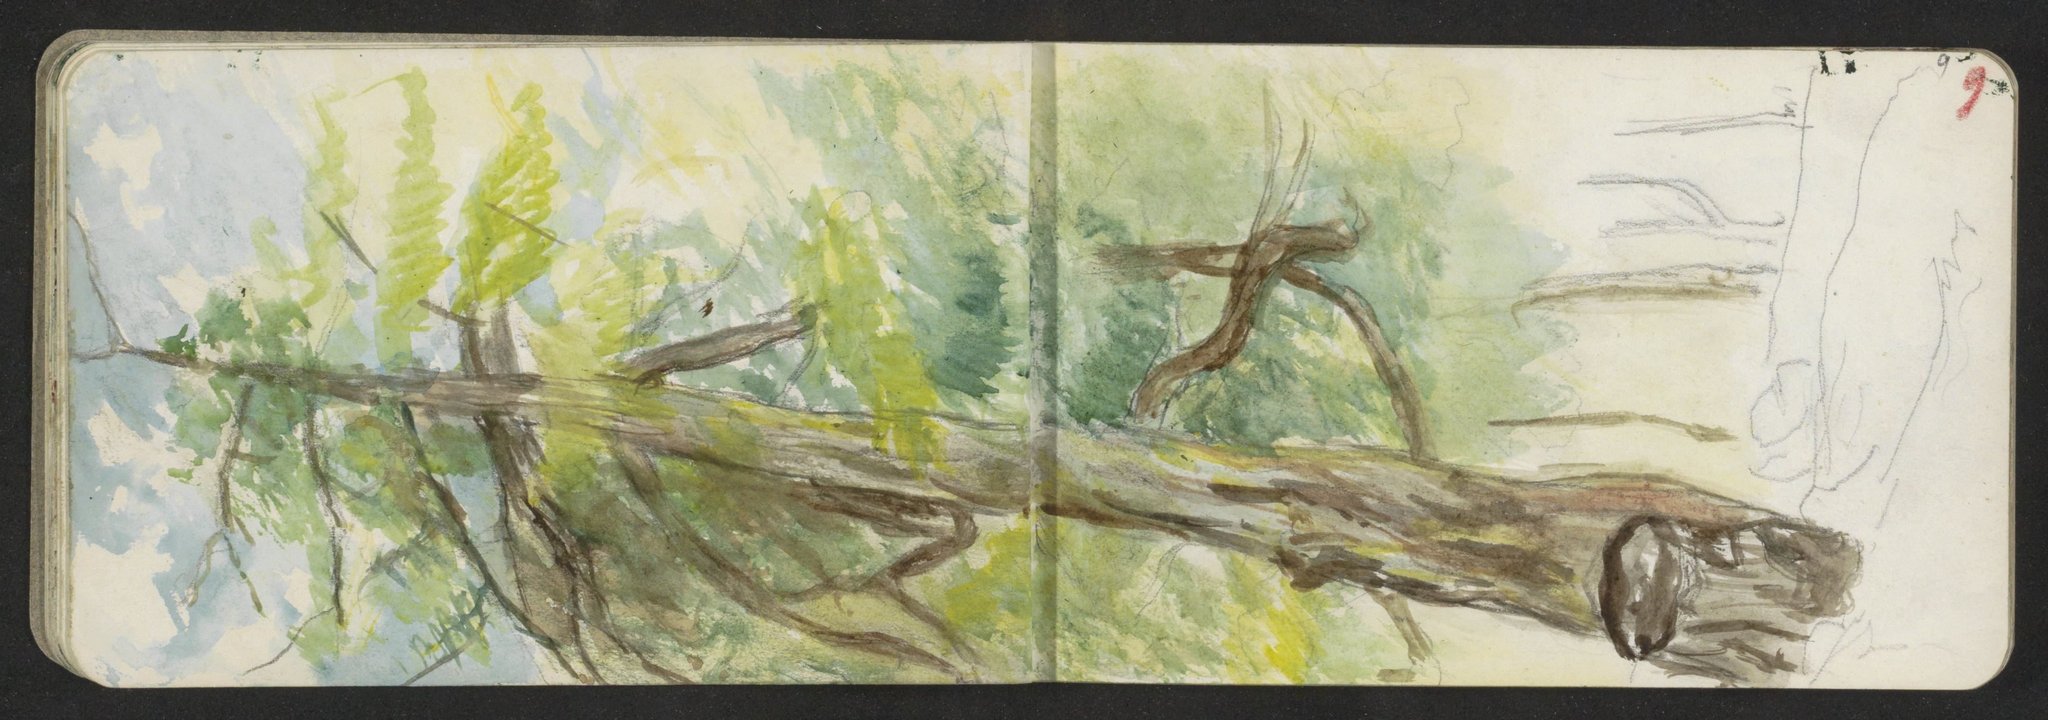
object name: sketchbook leaf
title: Boom in een bos in Pontresina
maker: jozef israëls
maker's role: draughtsman, painter, print maker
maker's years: 1824-1911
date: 1869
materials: paper, pencil, watercolor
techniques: brush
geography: pontresina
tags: forest, wood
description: Blad 8 verso en 9 recto uit een schetsboek met 36 bladen.